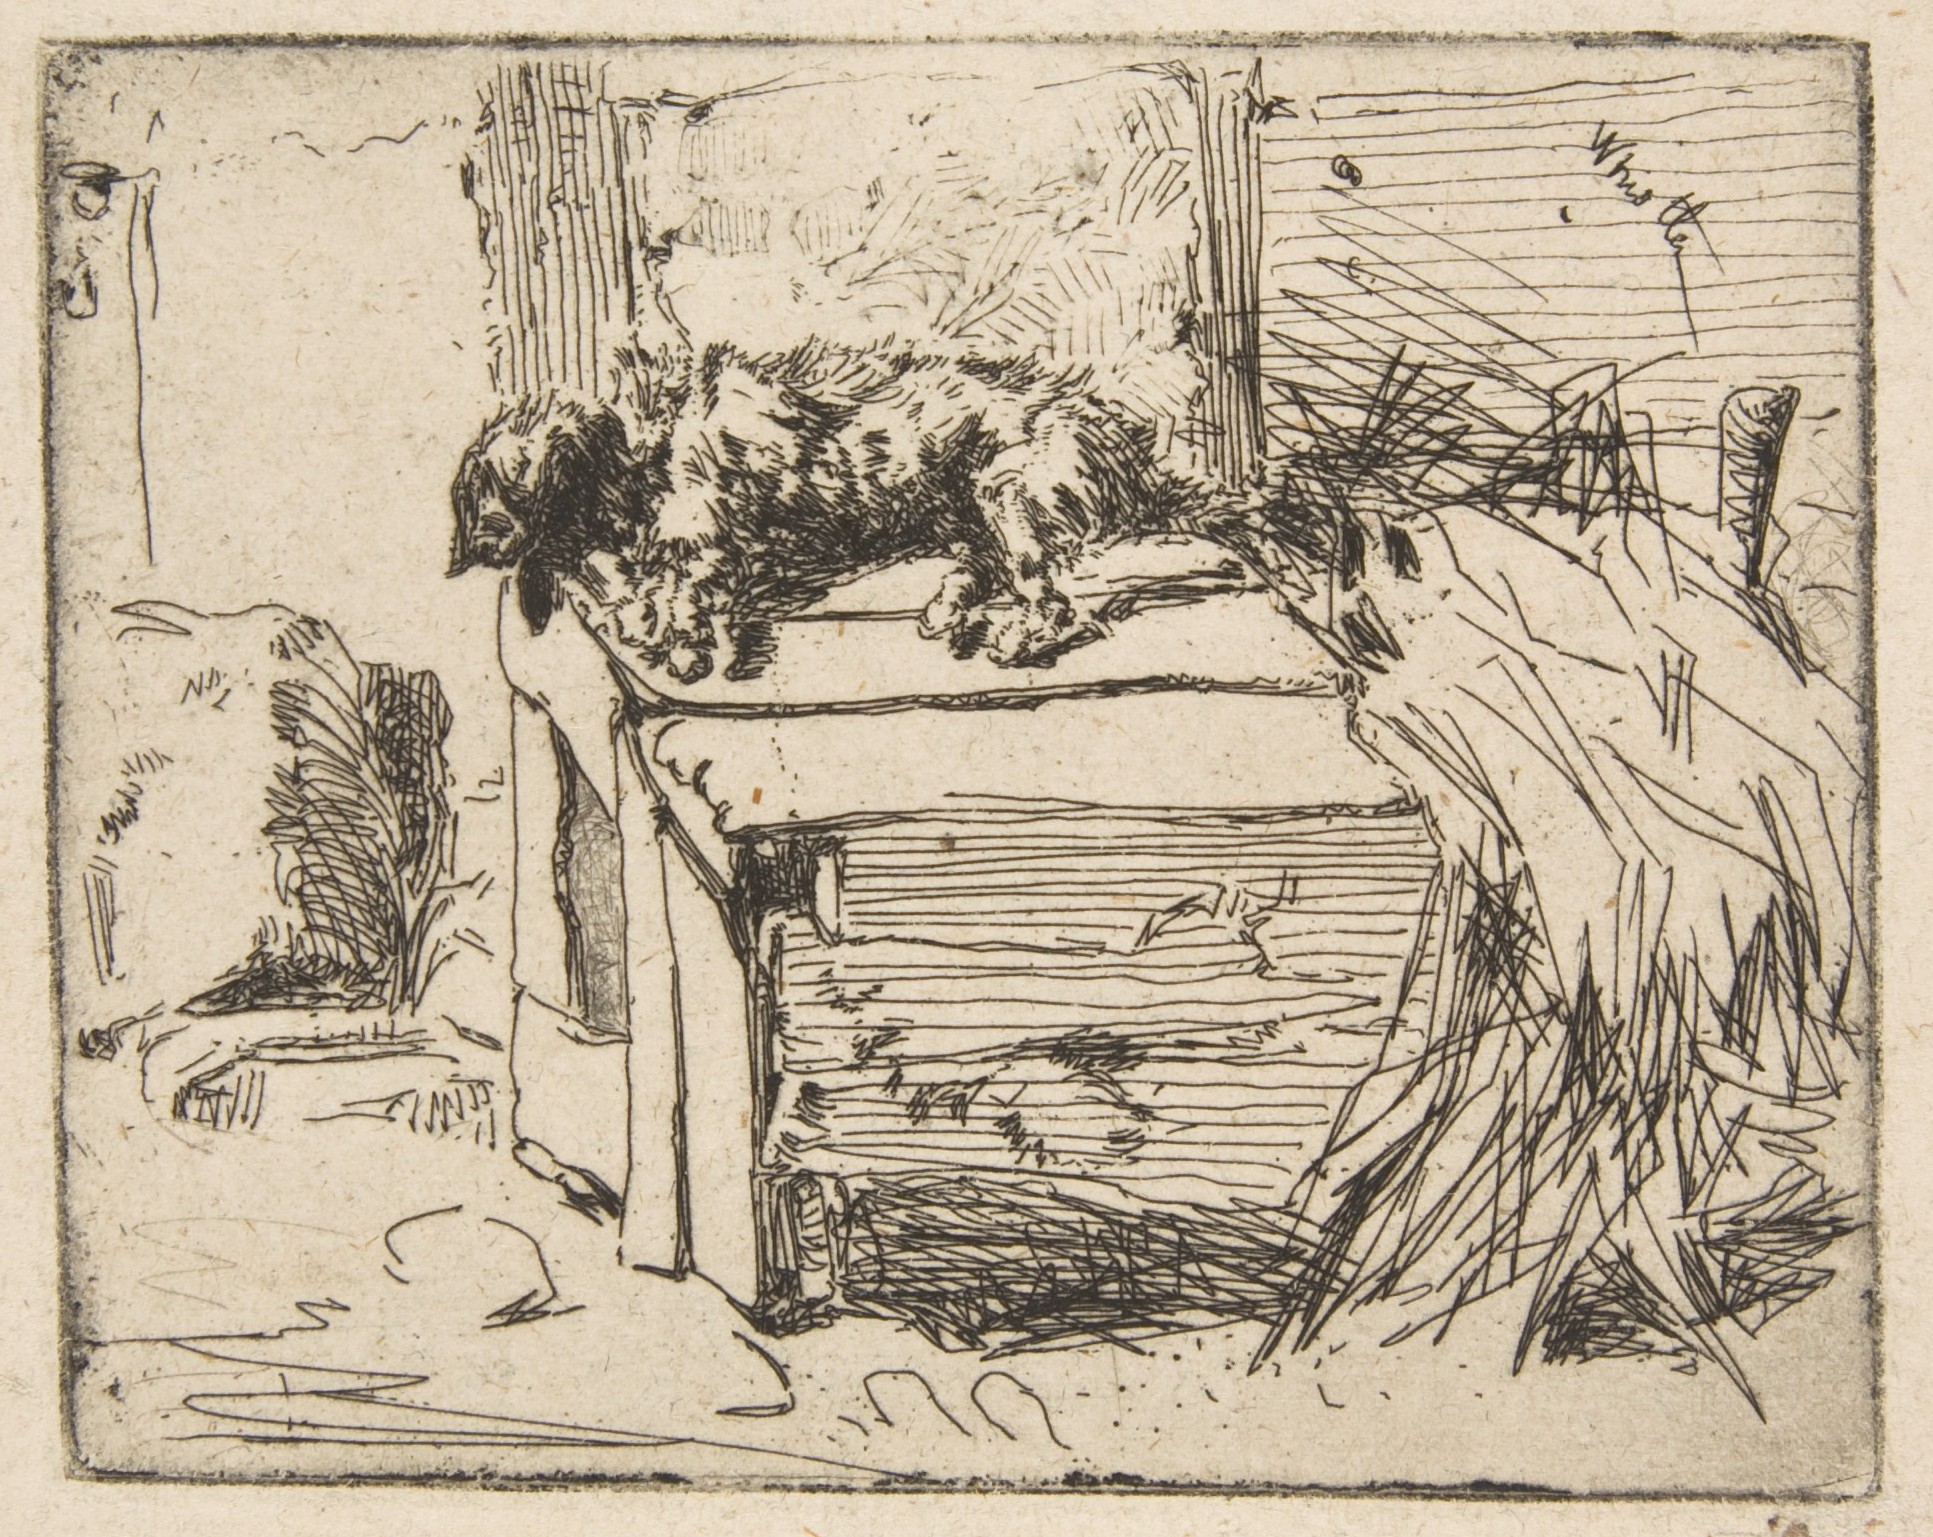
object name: print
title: The Dog on the Kennel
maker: james mcneill whistler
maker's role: artist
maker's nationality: american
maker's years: 1834-1903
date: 1858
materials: ink, paper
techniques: etching, printing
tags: dogs